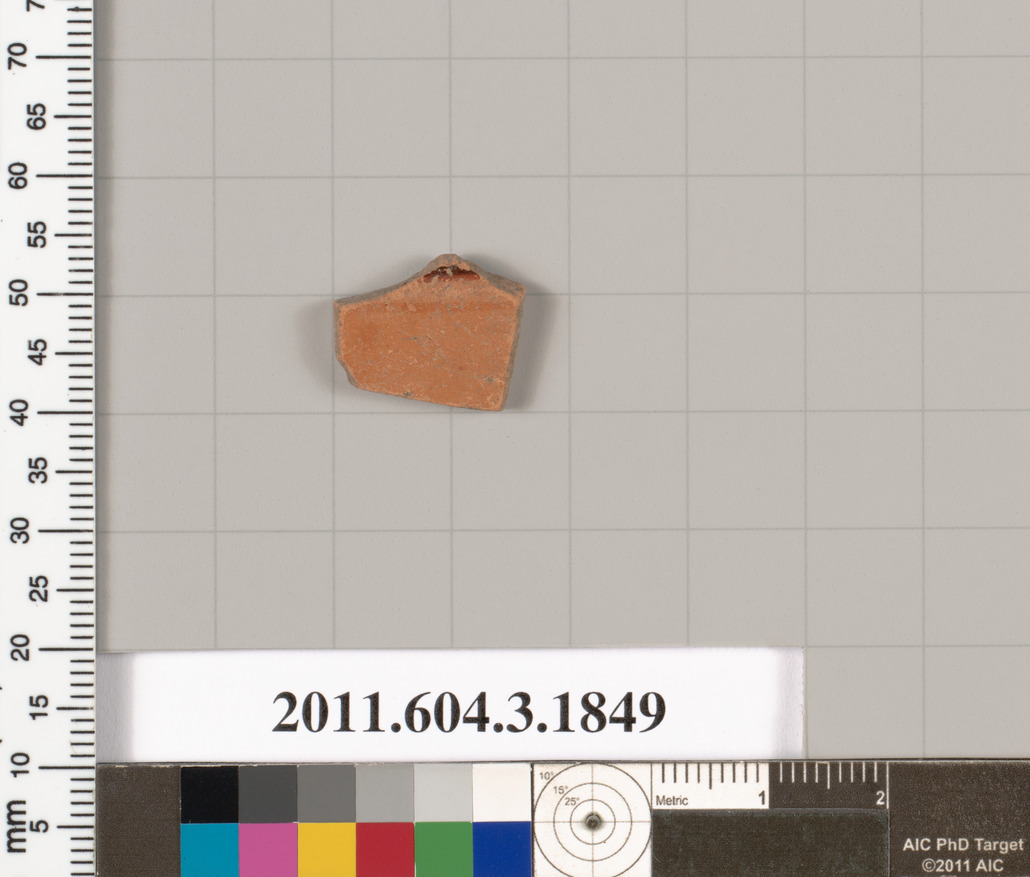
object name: kylix fragment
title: Terracotta fragment of a kylix: Lip cup (drinking cup)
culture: greek, attic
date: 560-525 BCE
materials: terracotta